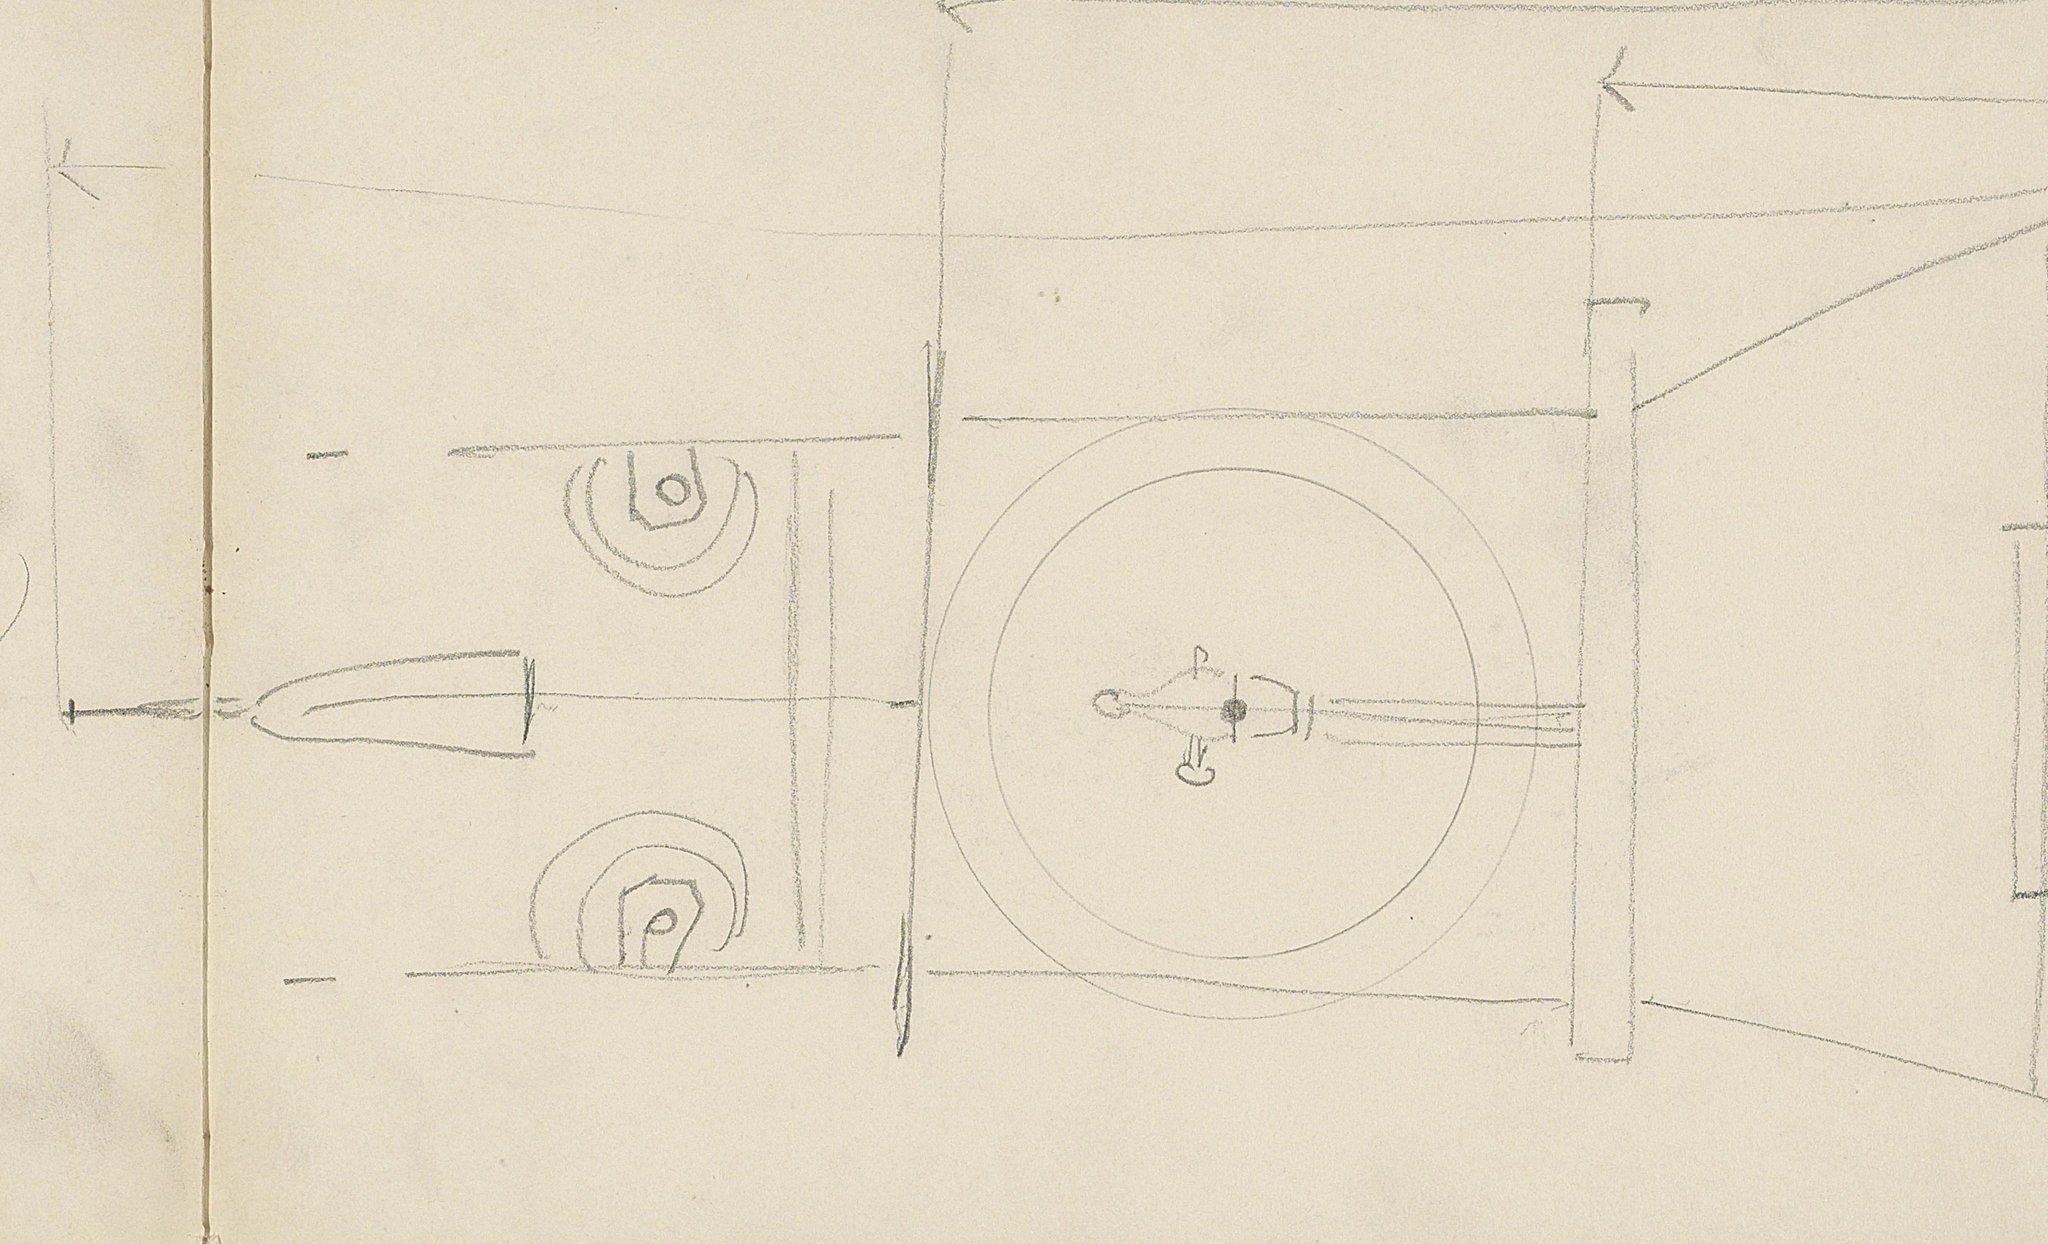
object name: sketchbook leaf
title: Studie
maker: carel adolph lion cachet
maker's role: draughtsman, print maker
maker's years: 1864-1945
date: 1908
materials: paper, pencil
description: Blad 8 recto uit een schetsboek met 25 bladen.